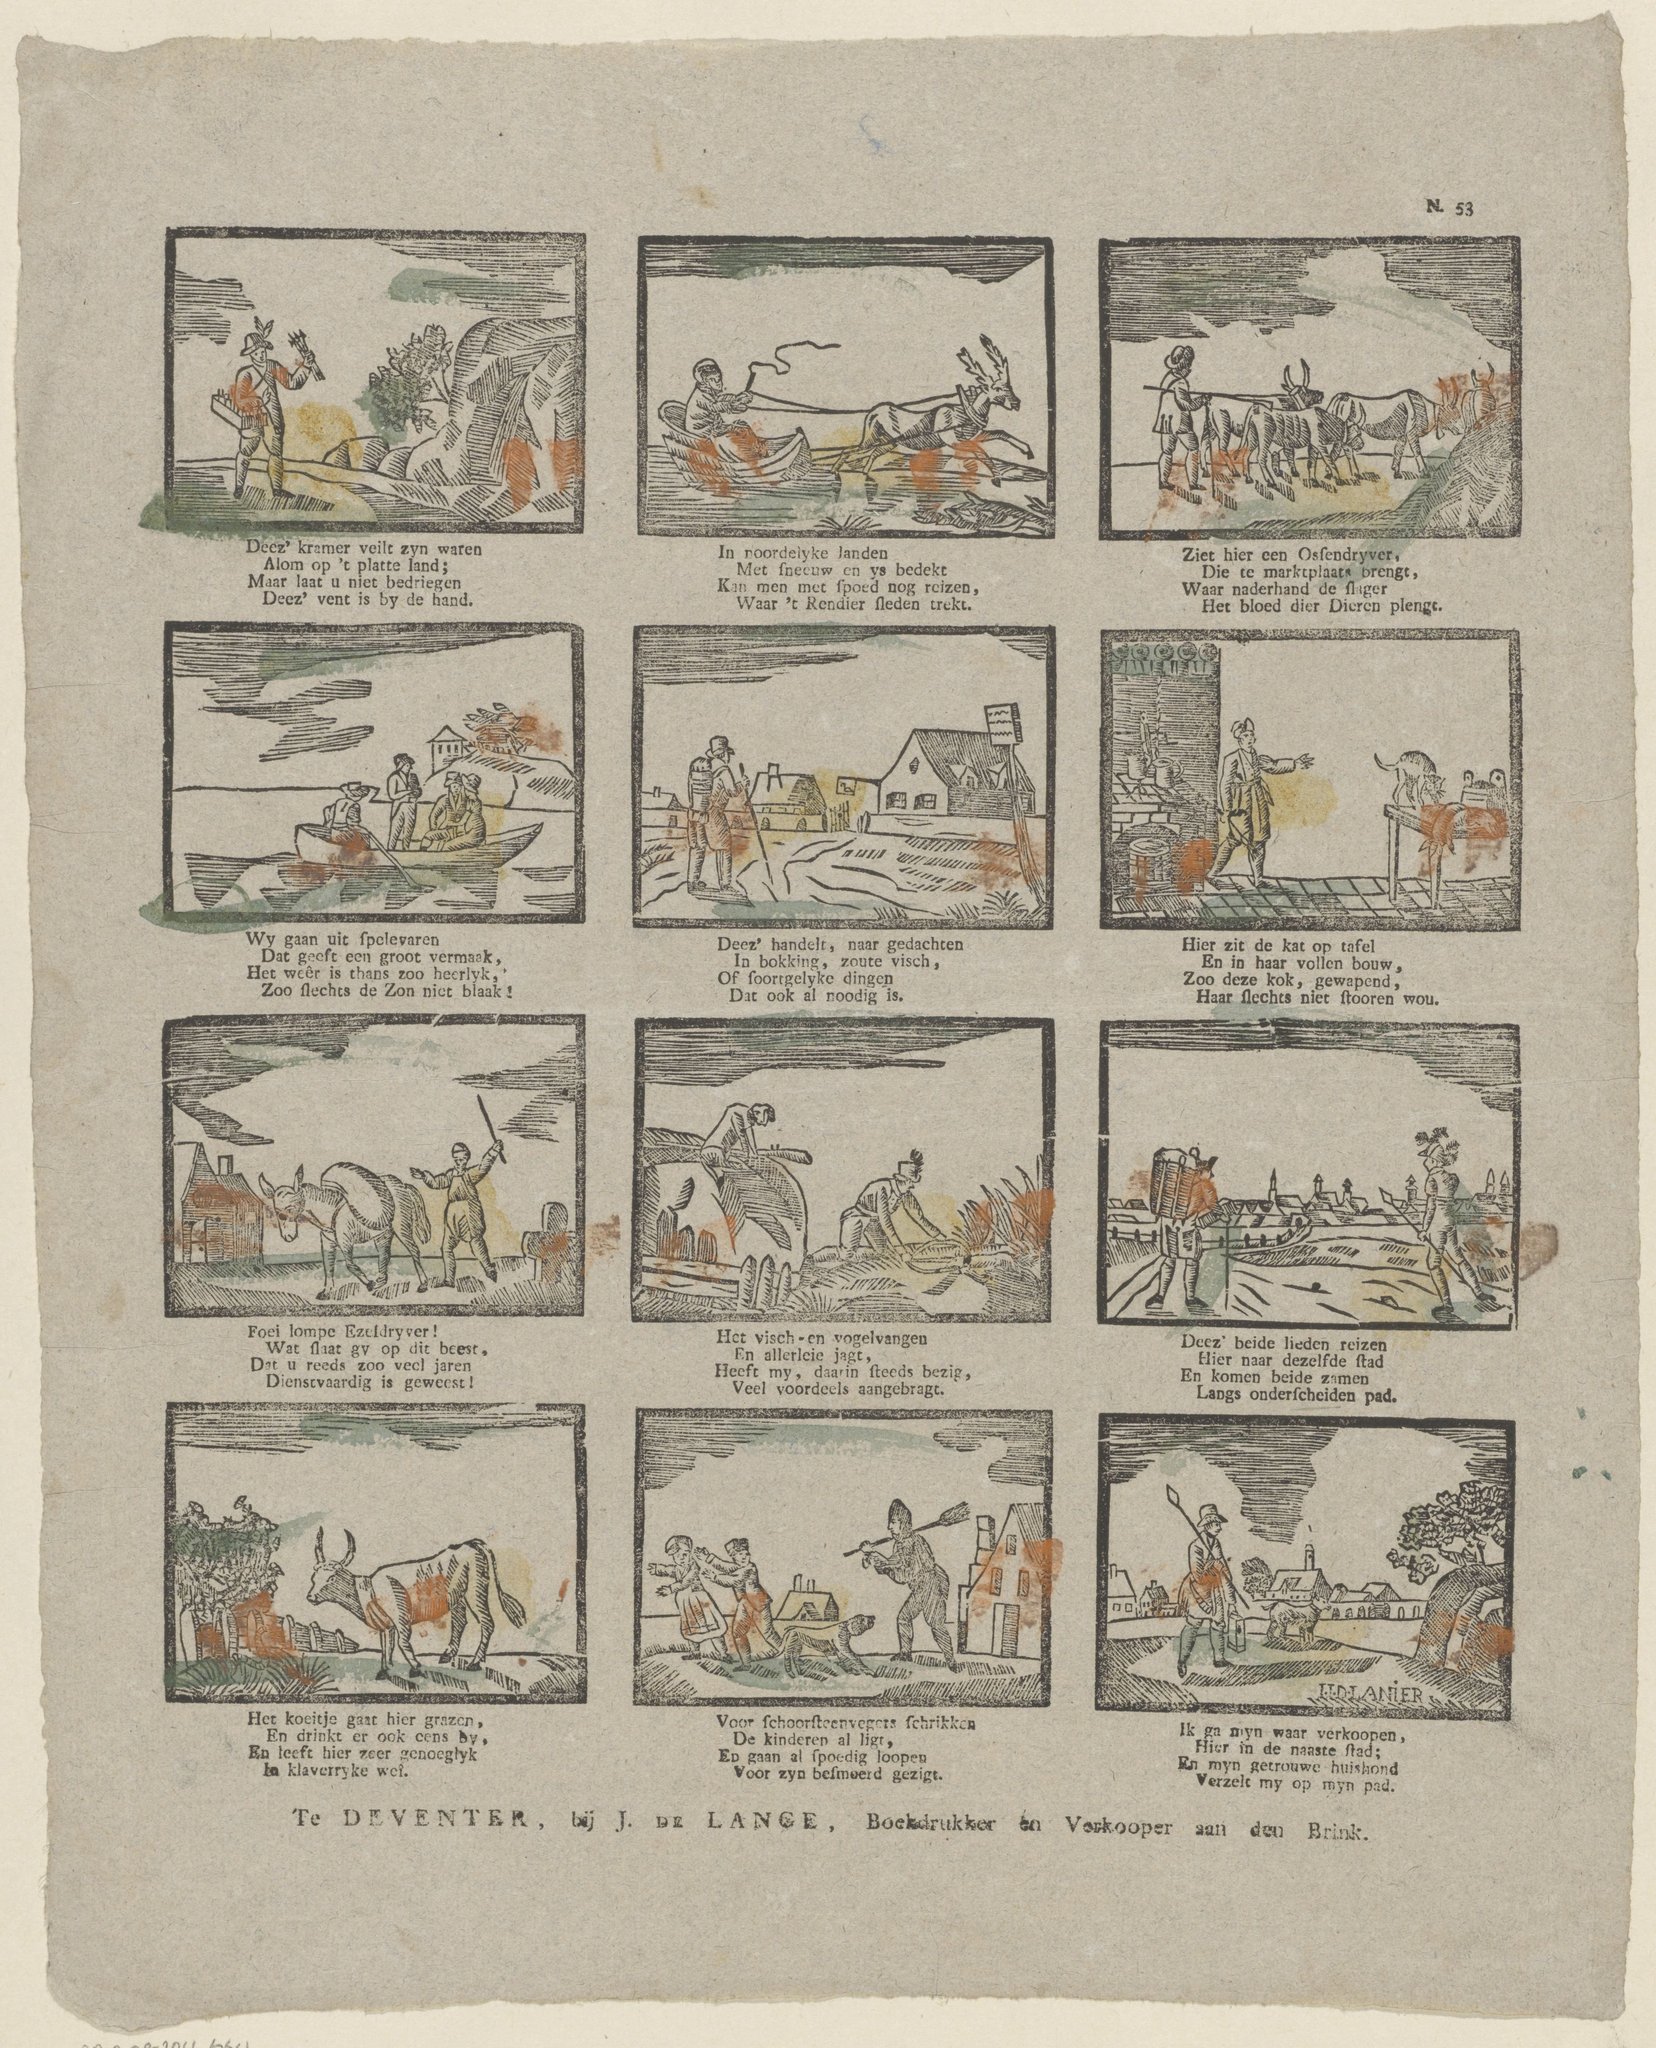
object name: print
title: Figuren, beroepen en bezigheden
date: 1822-1849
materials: paper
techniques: colour, letterpress printing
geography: deventer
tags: handicrafts ~ maintenance and repair, human types, farmers, street-trader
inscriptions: collector's mark: Lugt 2760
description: Blad met 4 voorstellingen van verschillende figuren, beroepen en bezigheden. Onder elke voorstelling een vierregelig vers. Genummerd rechtsboven: N. 53.